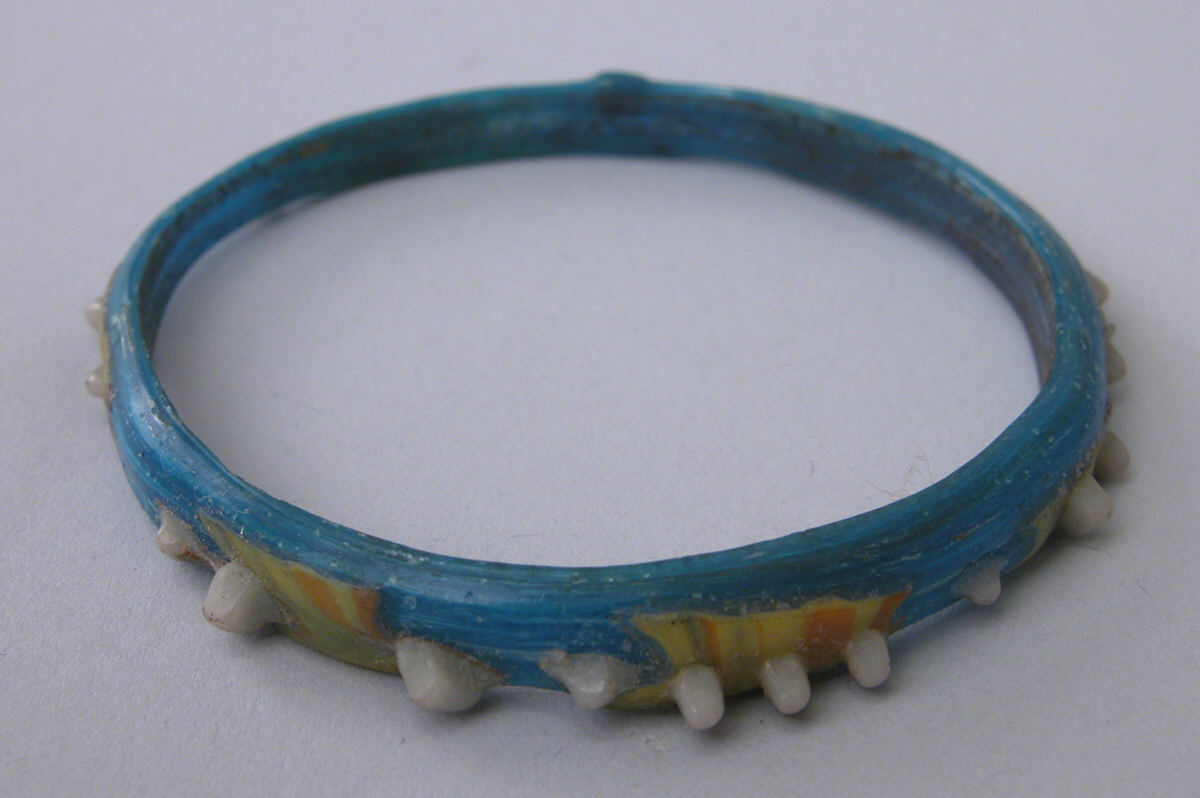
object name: bracelet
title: Bracelets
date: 1301-1500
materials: glass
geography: egypt or syria